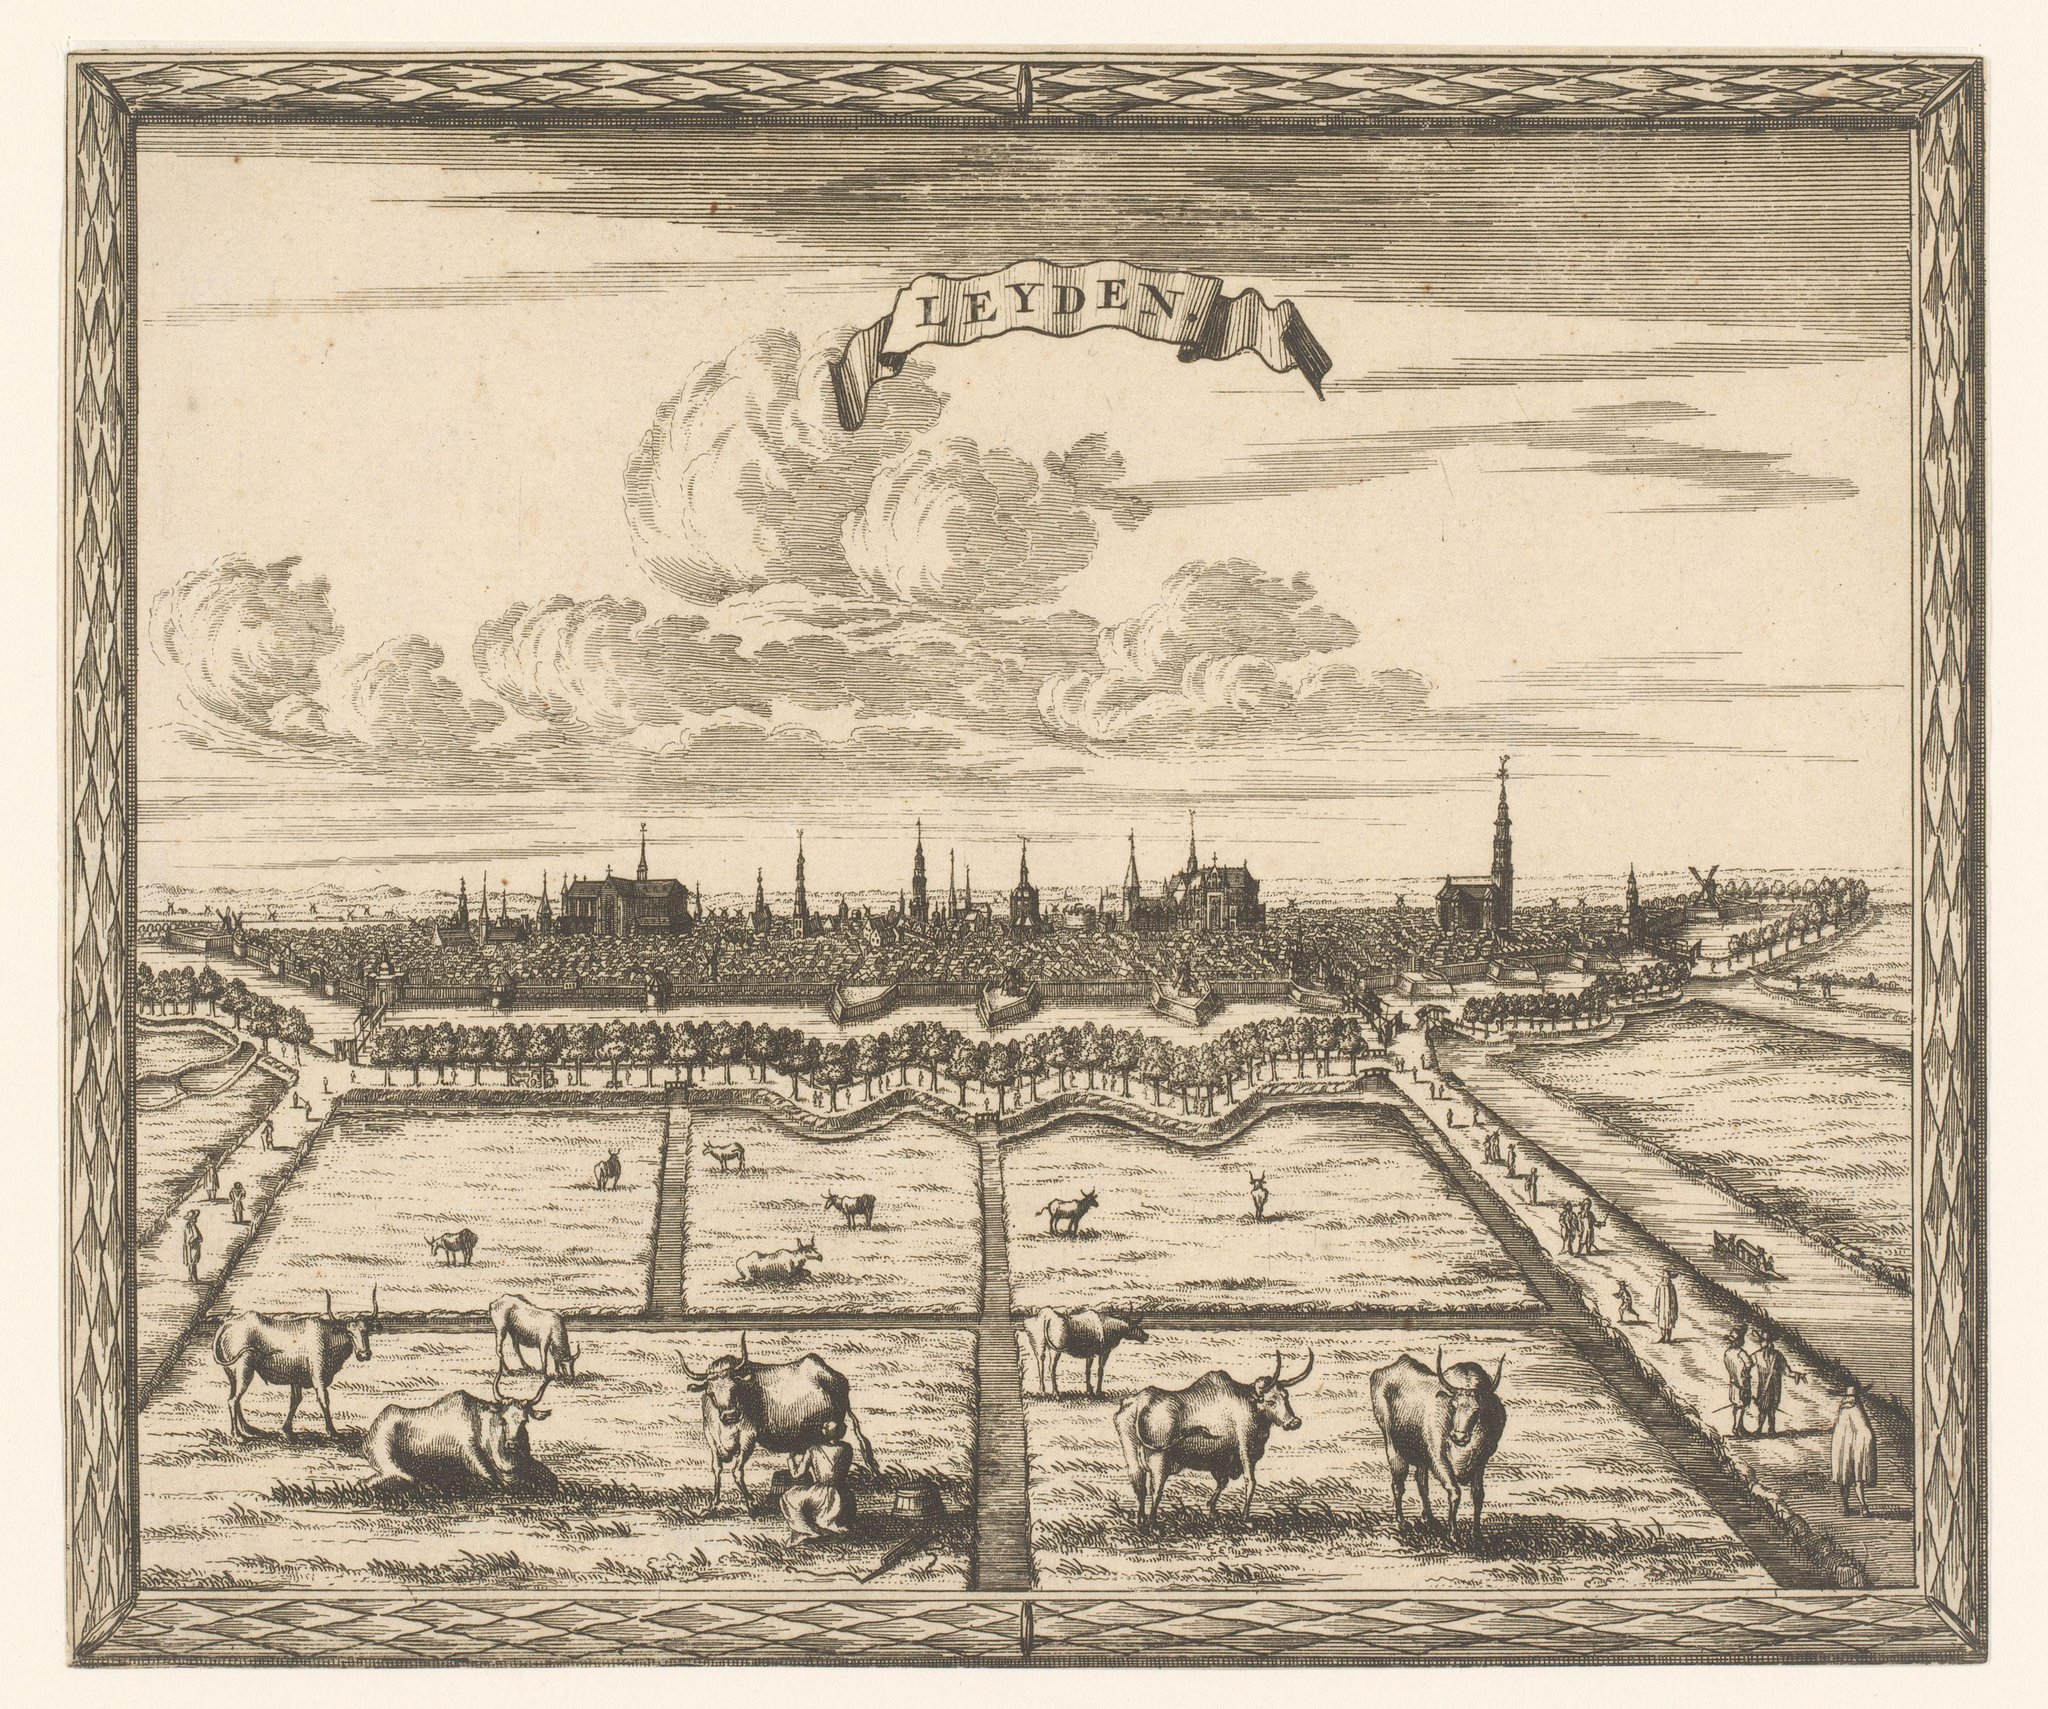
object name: print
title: Leyden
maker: Anonymous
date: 1600-1699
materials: paper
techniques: etching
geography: netherlands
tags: prospect of city, town panorama, silhouette of city, leiden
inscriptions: collector's mark: Lugt 240, inscription: ‘Overvoorde 625 l[...]’